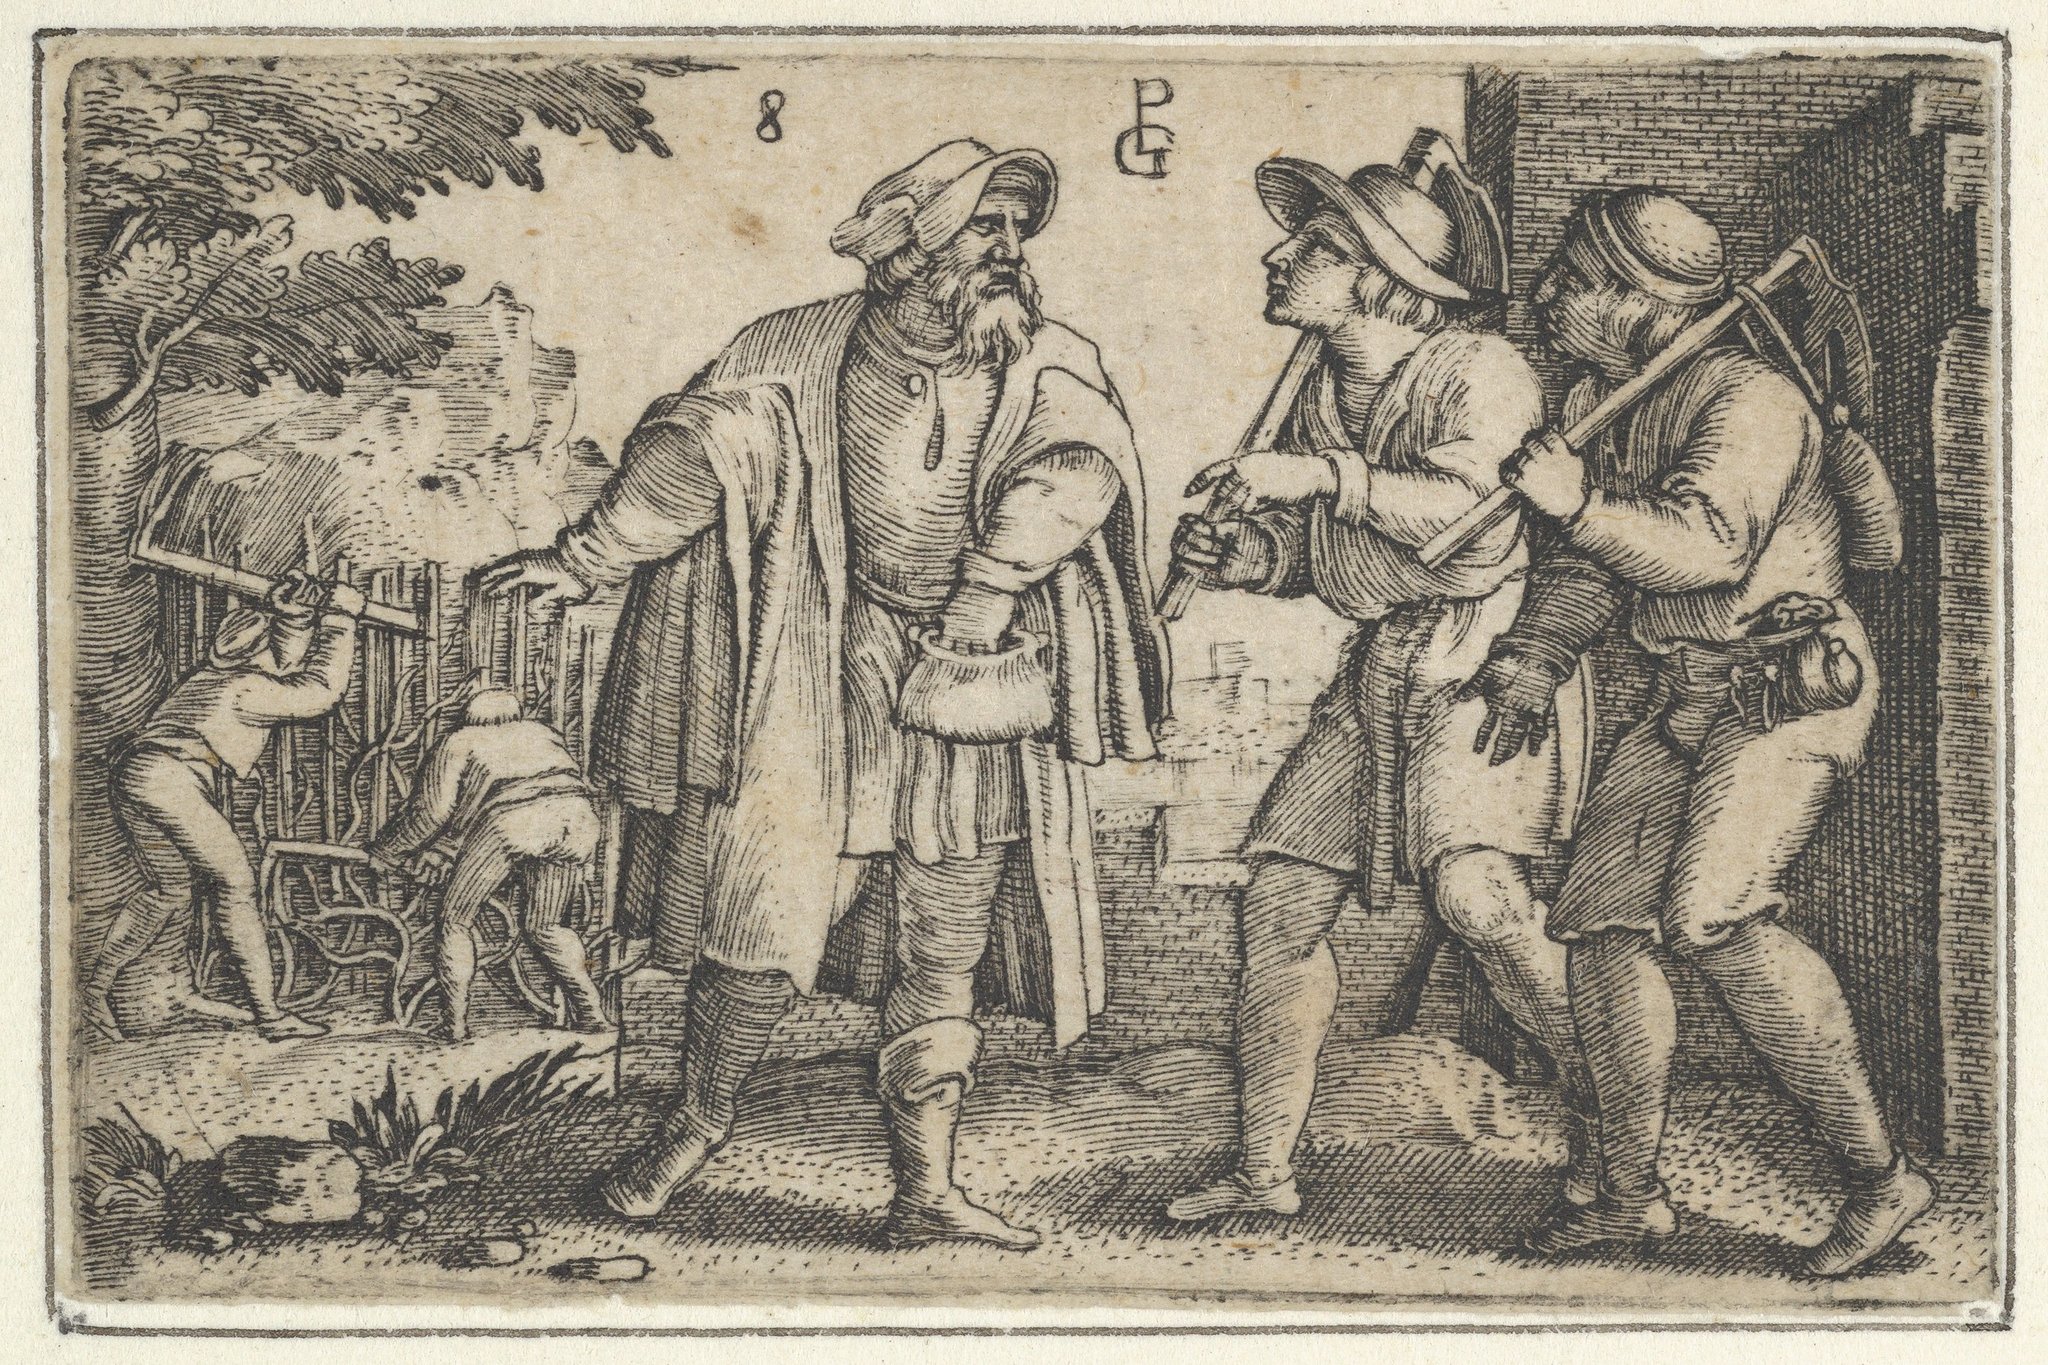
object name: print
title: The Parable of the Father and His Two Sons in the Vineyard, from The Story of Christ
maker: georg pencz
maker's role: artist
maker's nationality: german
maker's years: 1500-1550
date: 1534-1535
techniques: engraving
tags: boys,fathers,working